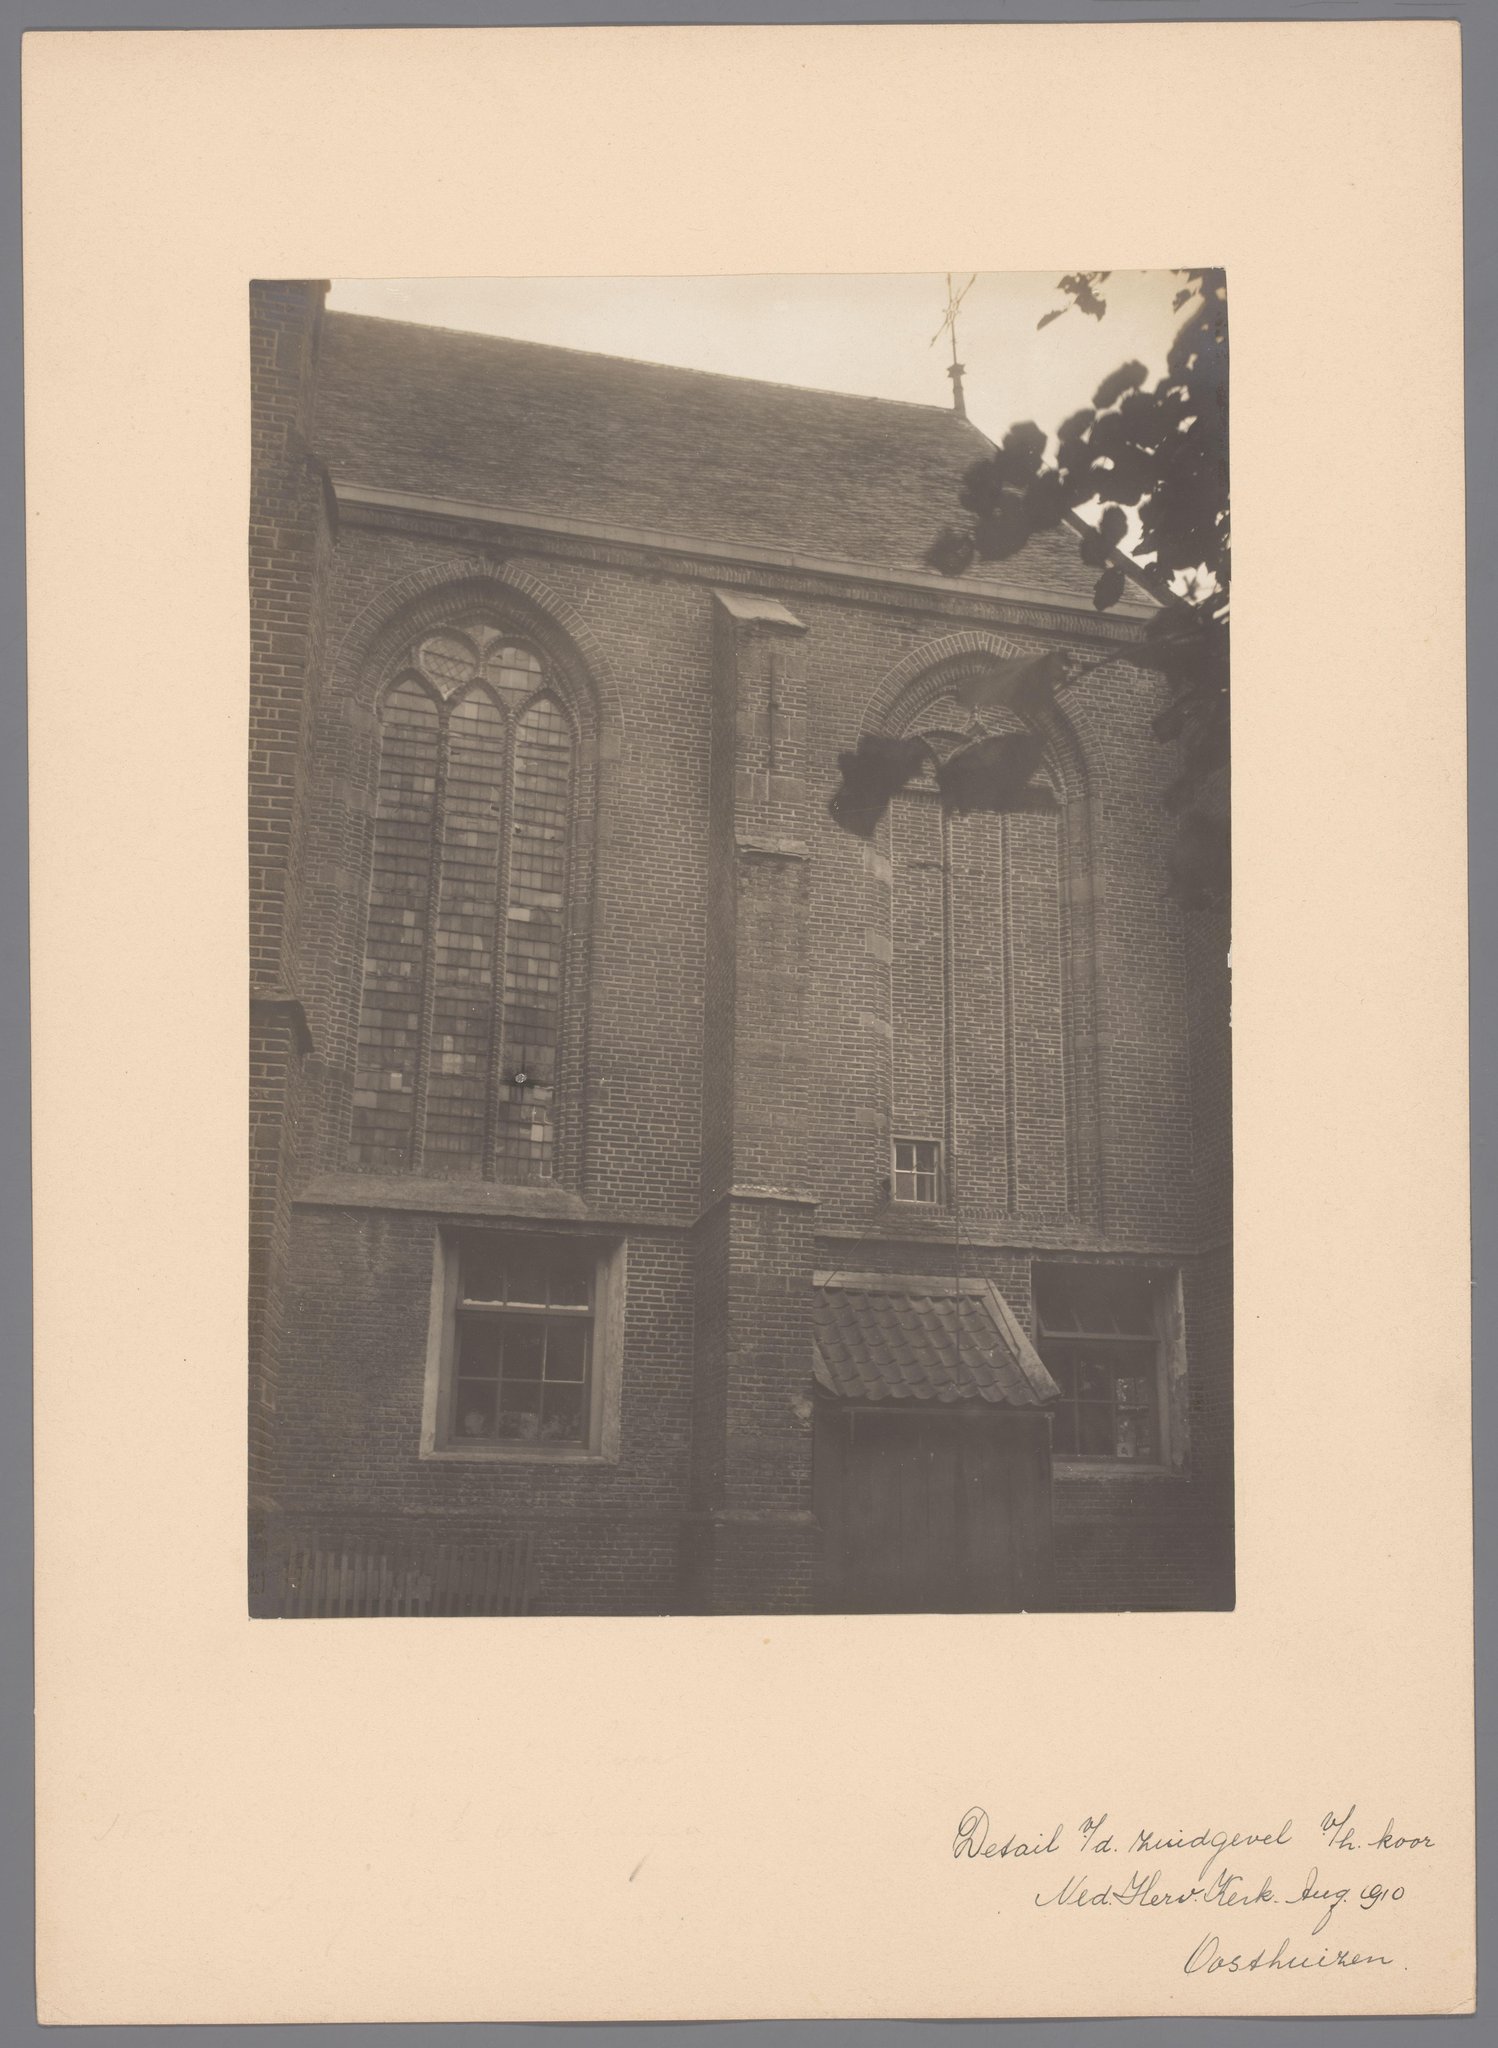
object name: photograph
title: Detail van de zuidgevel van het koor van de Grote Kerk te Oosthuizen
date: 1910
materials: cardboard, photographic support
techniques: gelatin silver print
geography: oosthuizen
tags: church (exterior)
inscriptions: annotation: ‘Detail v/d zuidgevel v/h koor/ Ned. Herv. Kerk Aug. 1910/ Oosthuizen’, annotation: ‘Maria Tesselschade Roemer Visscher 1594-1649’